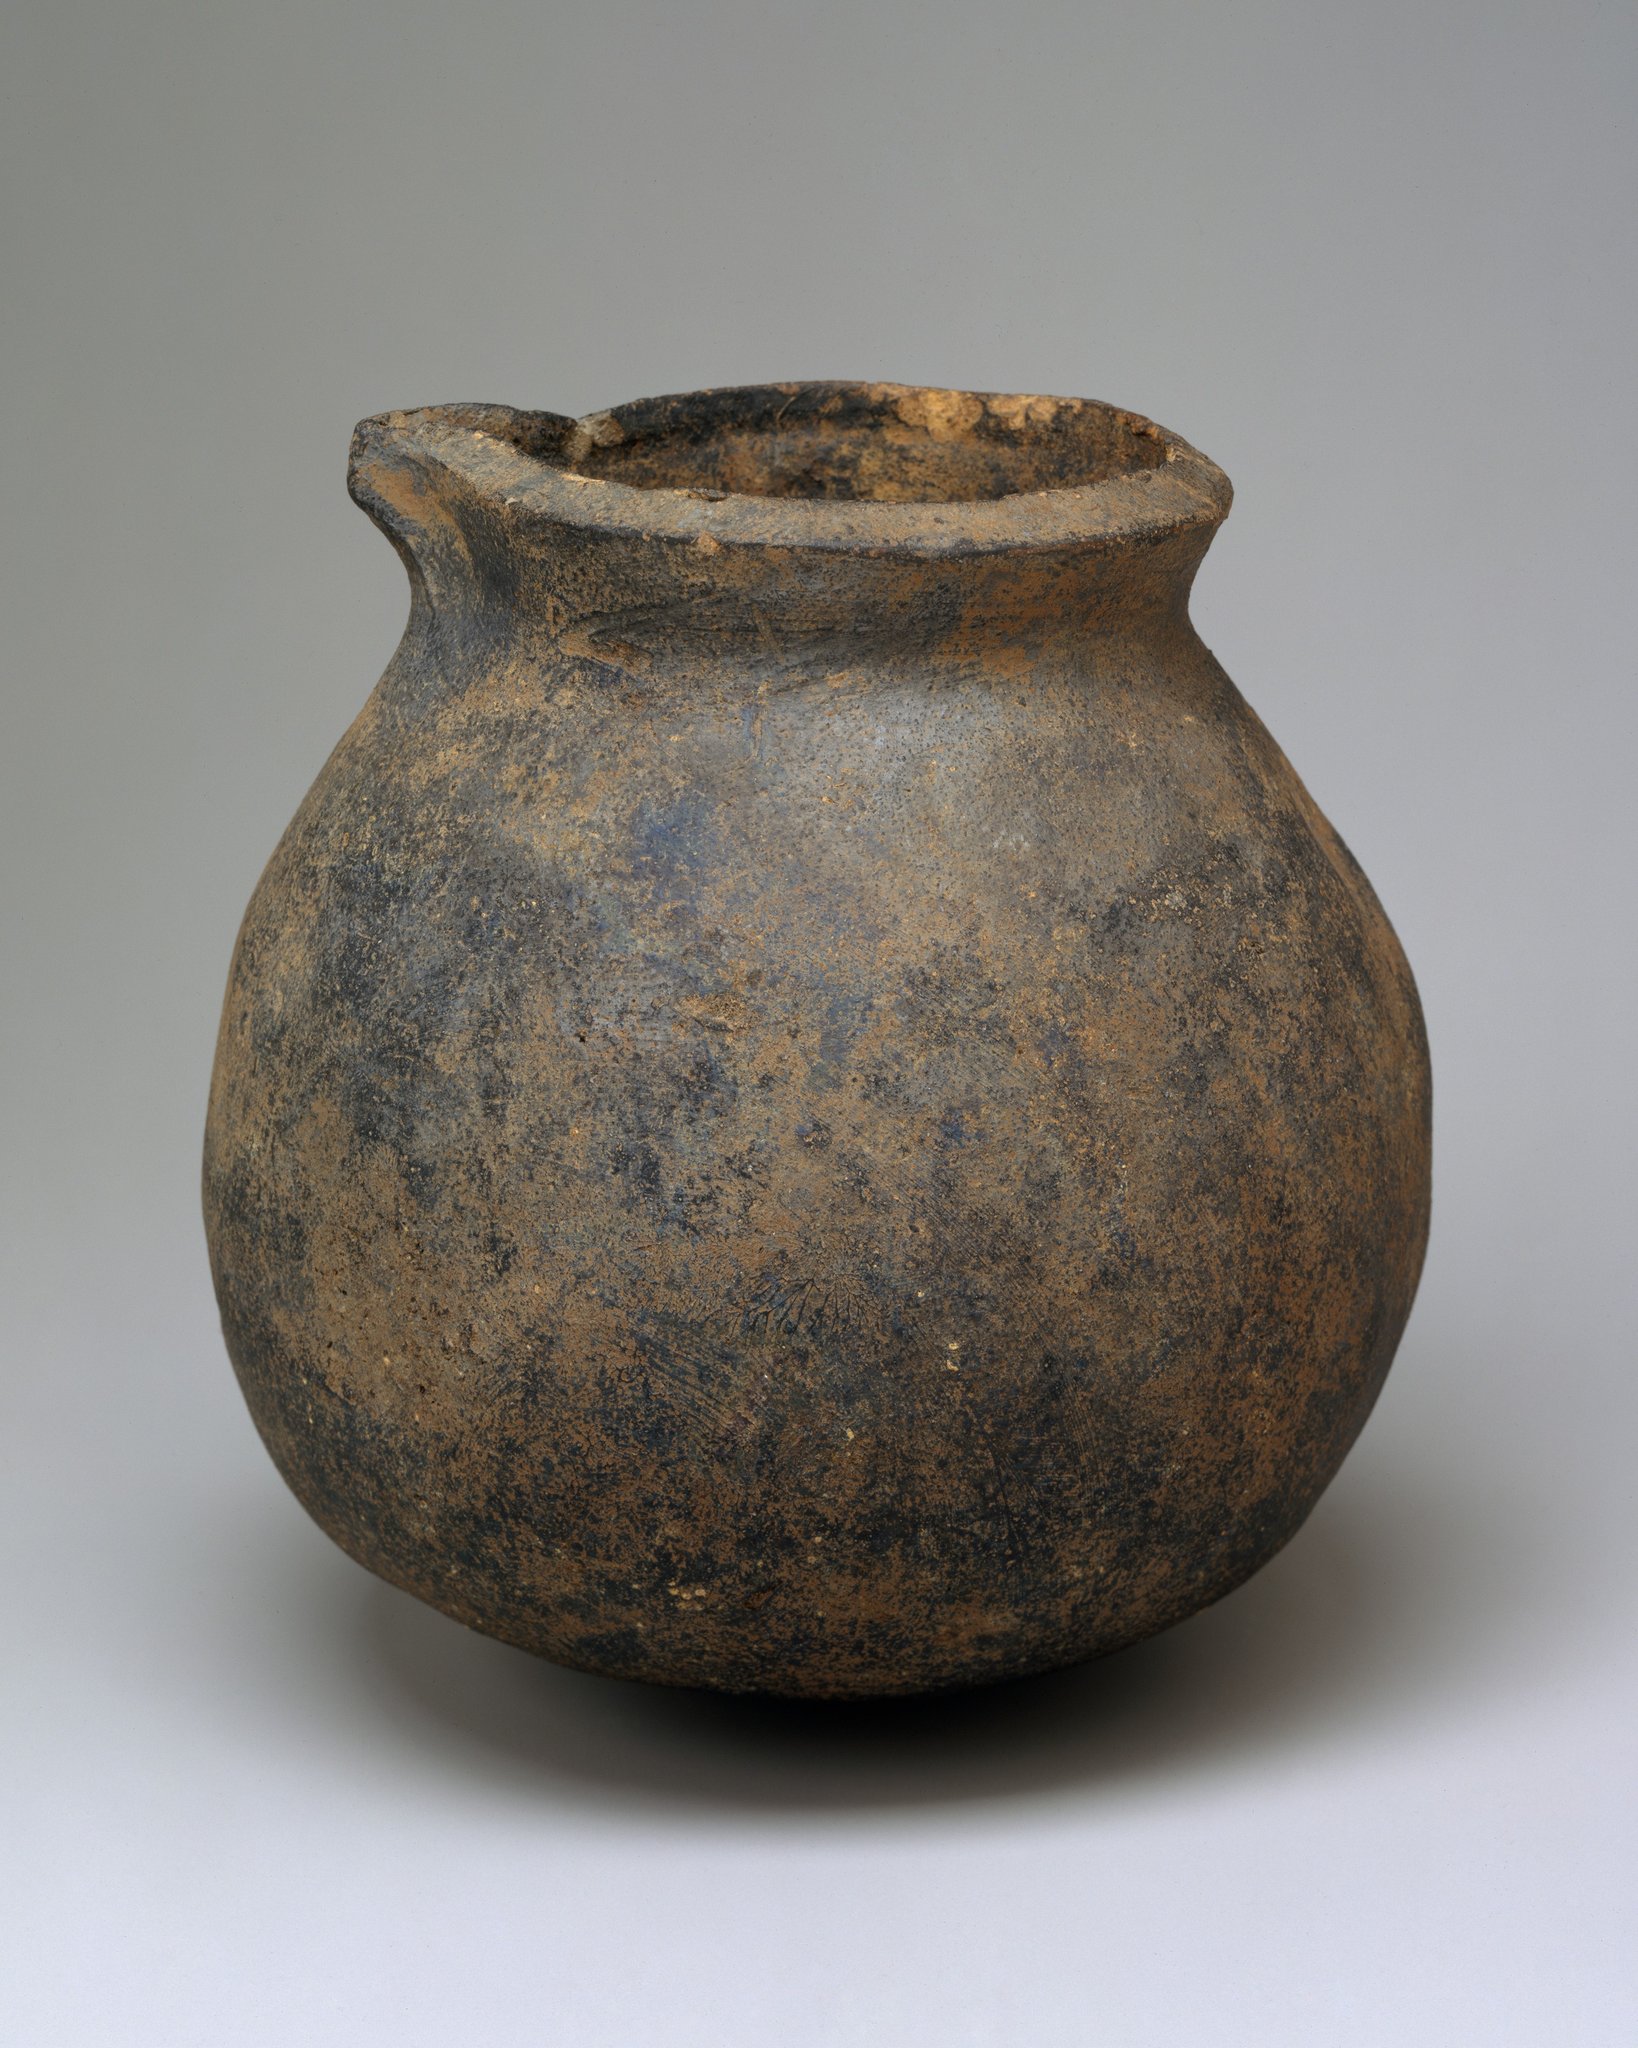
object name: jug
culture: german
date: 1101-1300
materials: earthenware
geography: germany